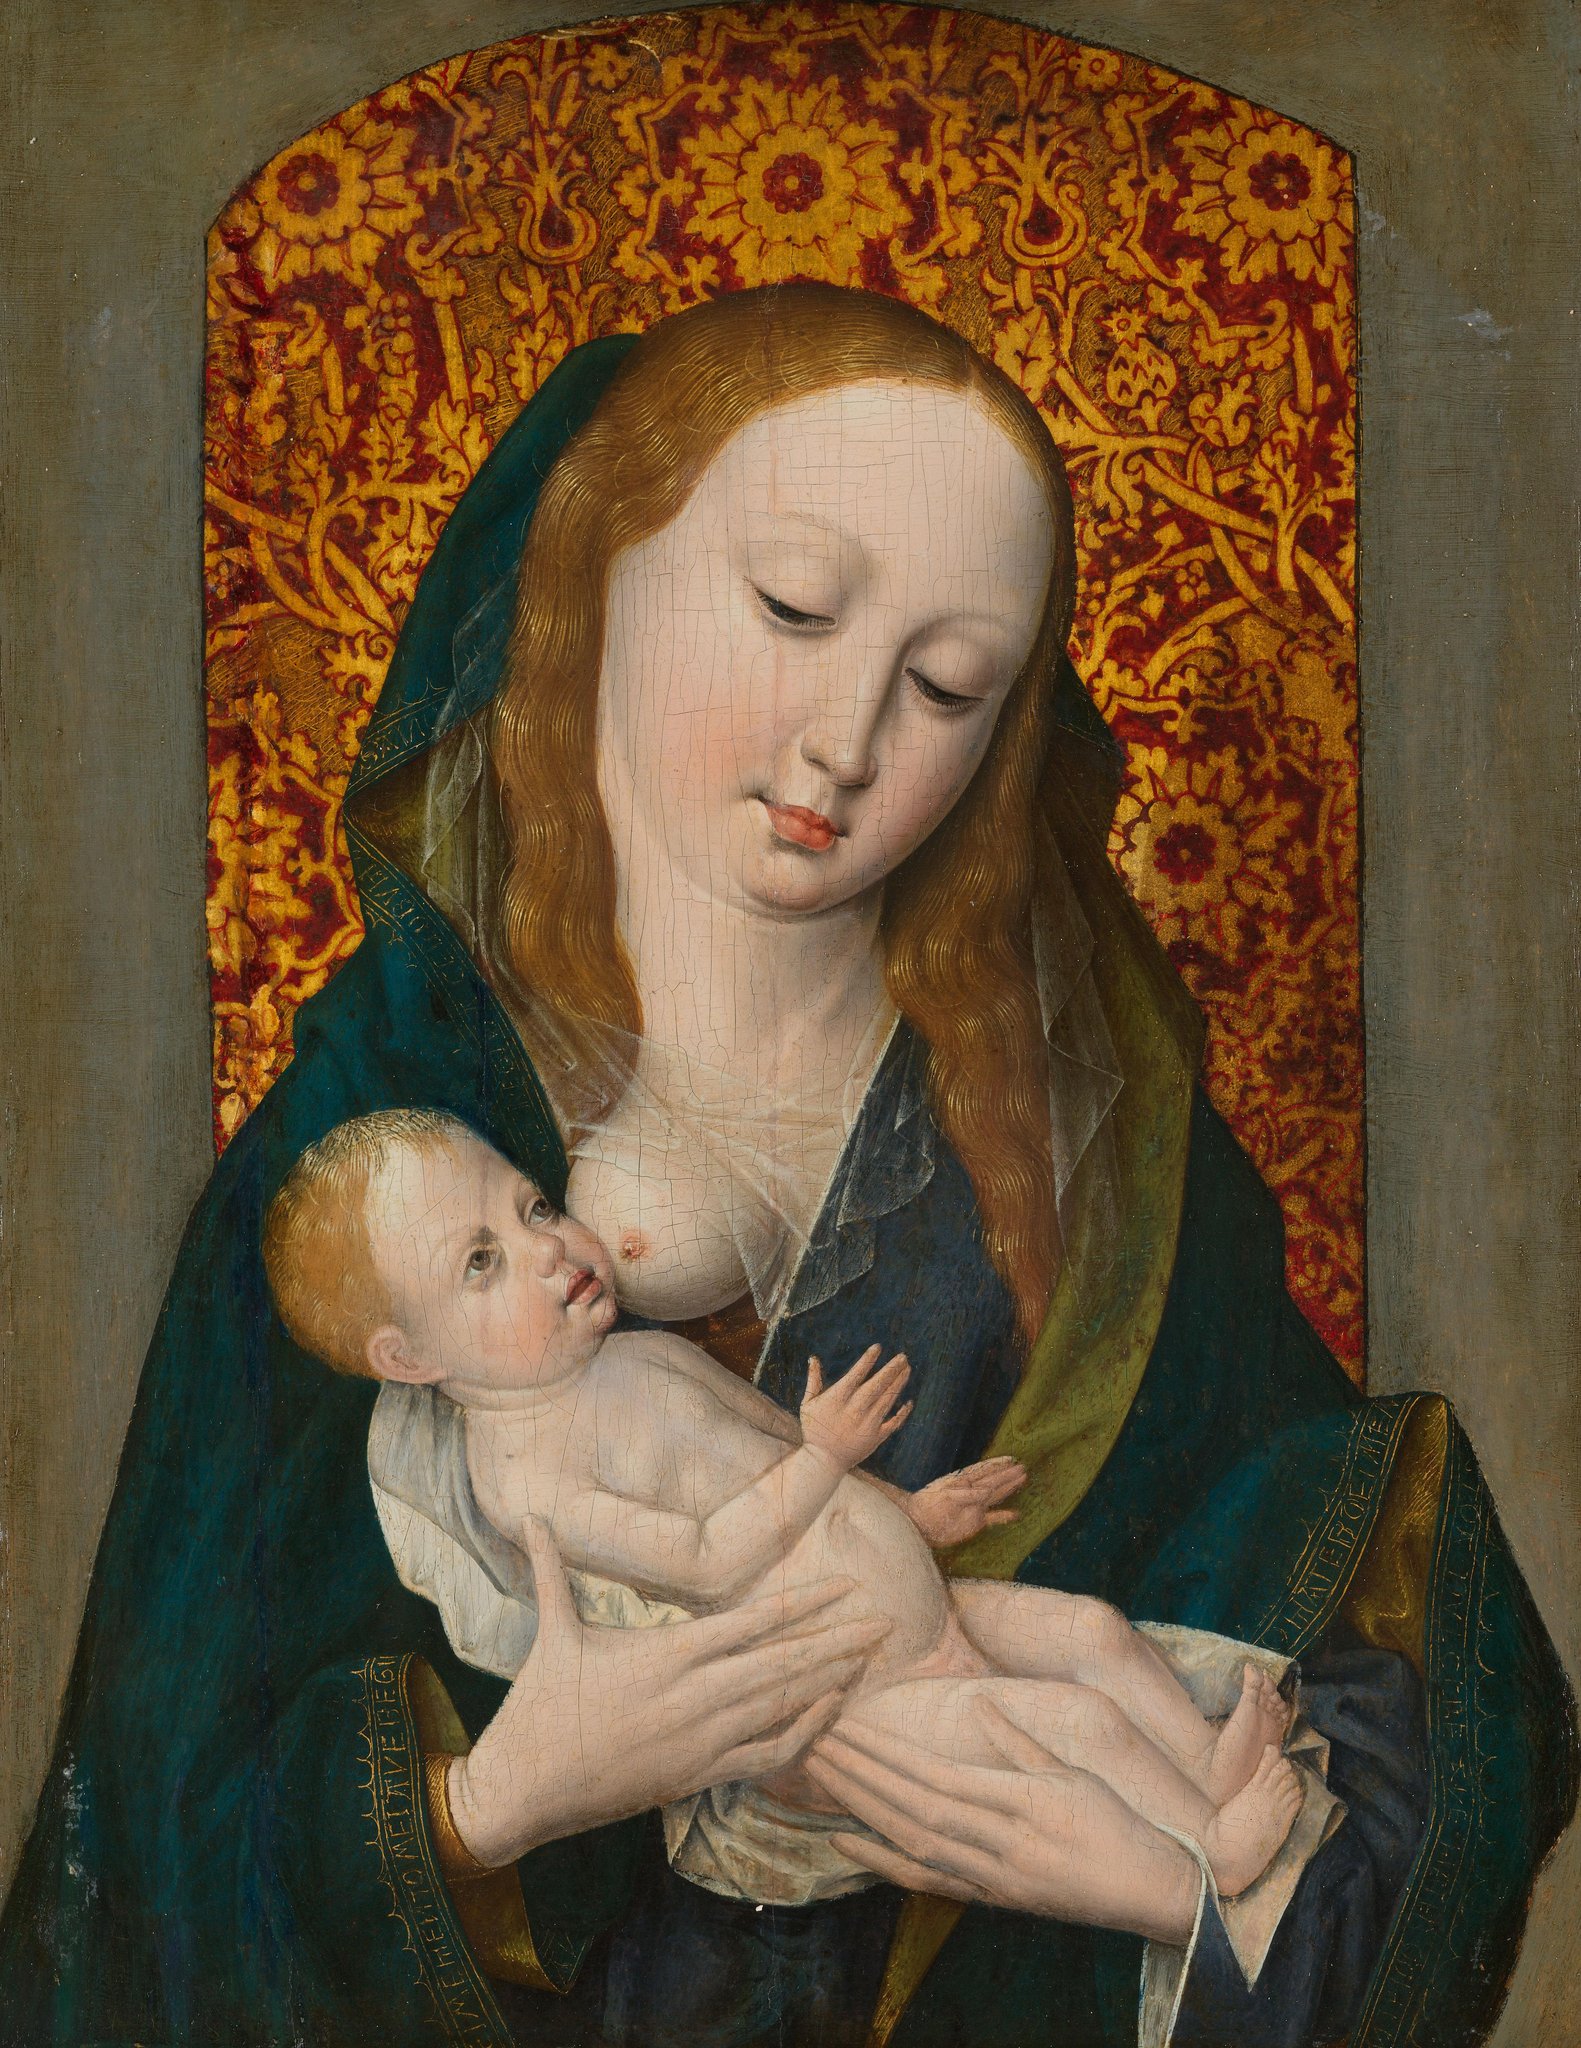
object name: painting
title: Virgin and Child (Madonna Lactans)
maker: Anonymous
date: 1500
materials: oil, panel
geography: southern netherlands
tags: madonna: mary standing (or half-length), christ-child close to her bosom, 'ablactatio'; christ not drinking, mary's breast bare ~ madonna-representations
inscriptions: inscription, Around the cuffs of the Virgin’s sleeves, outer left cuff: ‘>[D?]EI MEMENTO MEI AVE REGIN[A] // AV’, inscription, Around the cuffs of the Virgin’s sleeves, outer right cuff: ‘O MATER DEI MEM[ENTO] // [S?]TOA DVLCERE AVE MATER DOMINI’, inscription, Along the edge of the Virgin’s hood to the left of her face: ‘AVE REGINA CELORUM AVE’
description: Maria met het kind aan de borst, ten halven lijve voor een draperie van goudbrokaat.